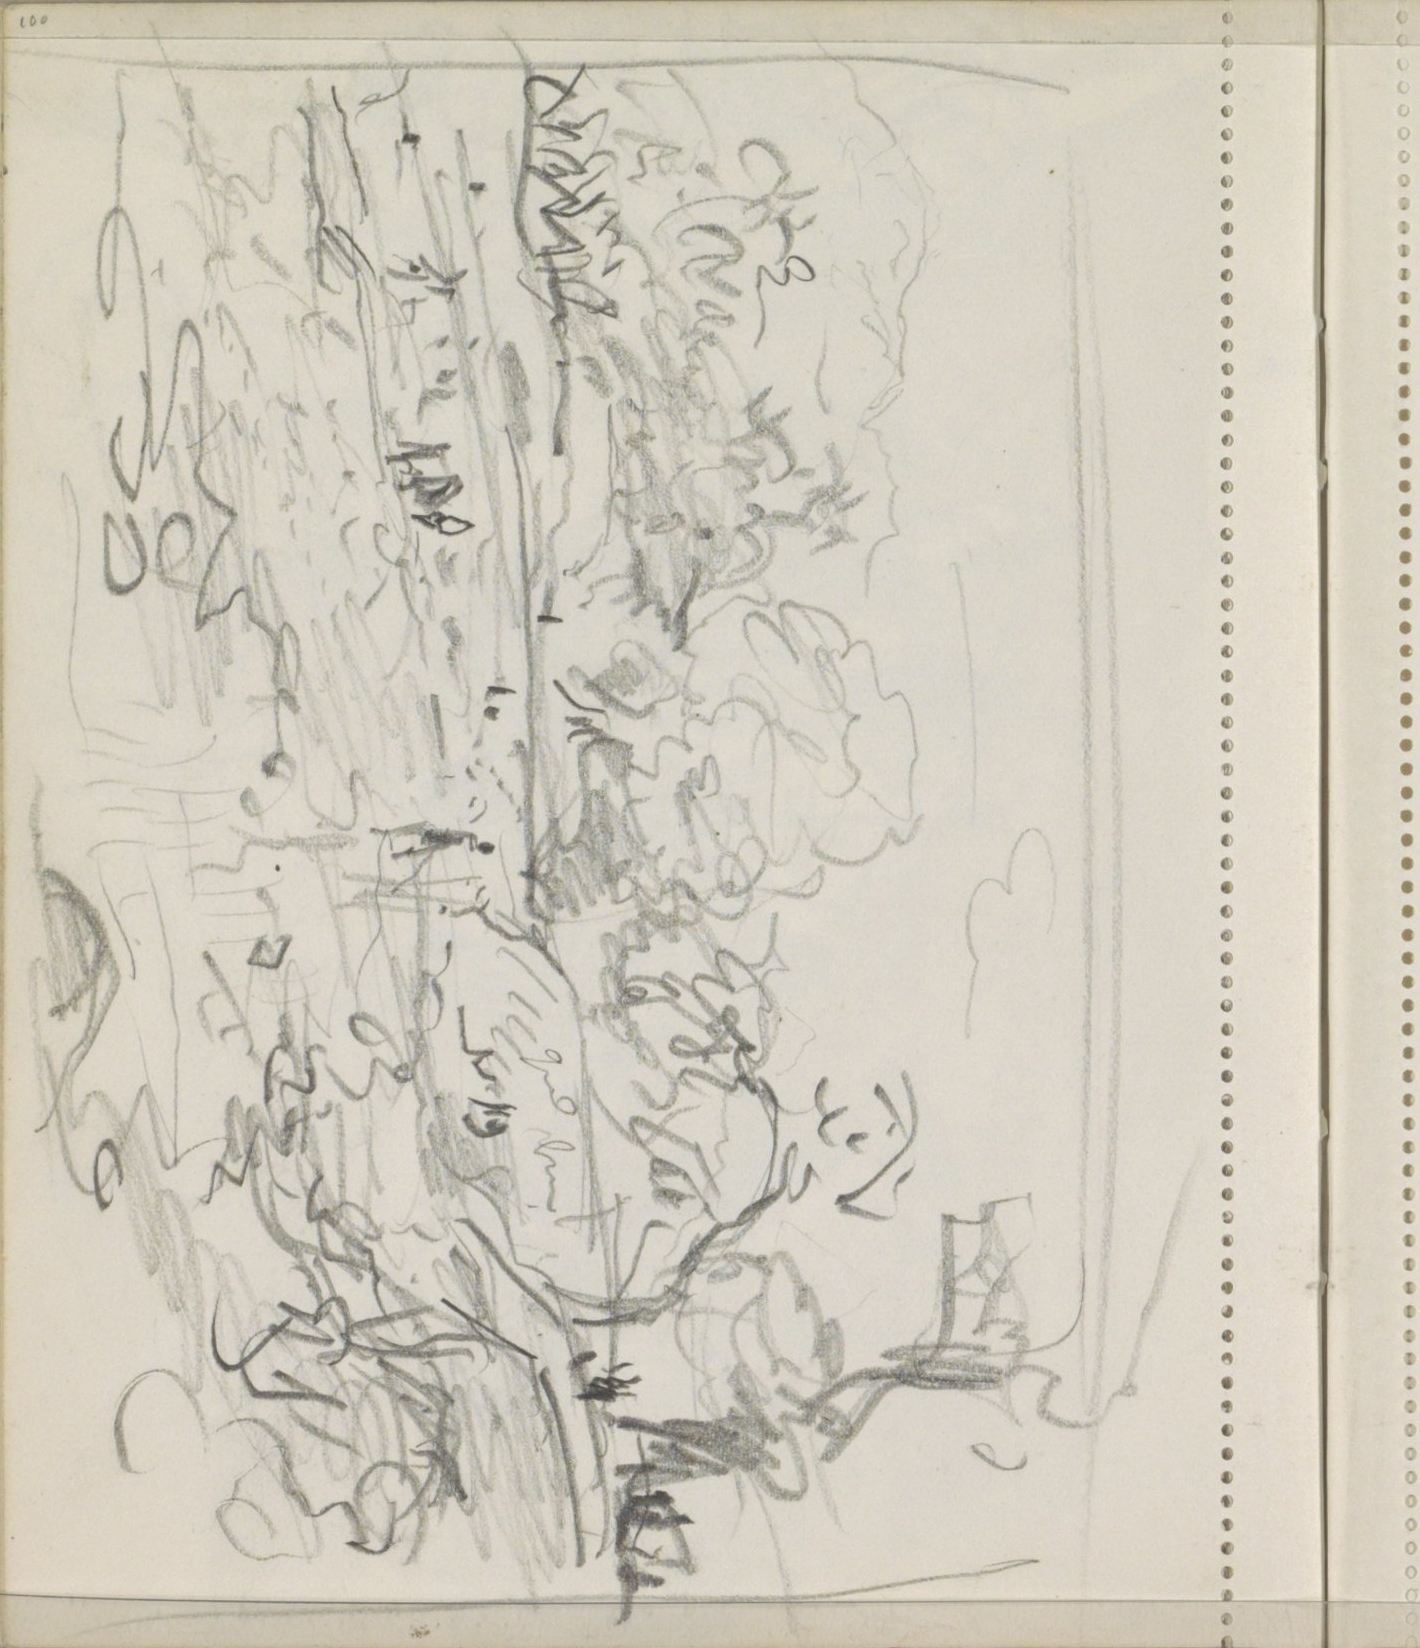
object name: sketchbook leaf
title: Landschap met arbeiders op een sawa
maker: marius bauer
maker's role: draughtsman, print maker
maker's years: 1867-1932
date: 1925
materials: paper, pencil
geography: indonesia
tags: sawahs, rice paddies, cultivation ~ agriculture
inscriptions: kleurnotitie, handgeschreven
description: Pagina 100 uit een schetsboek met 67 bladen.